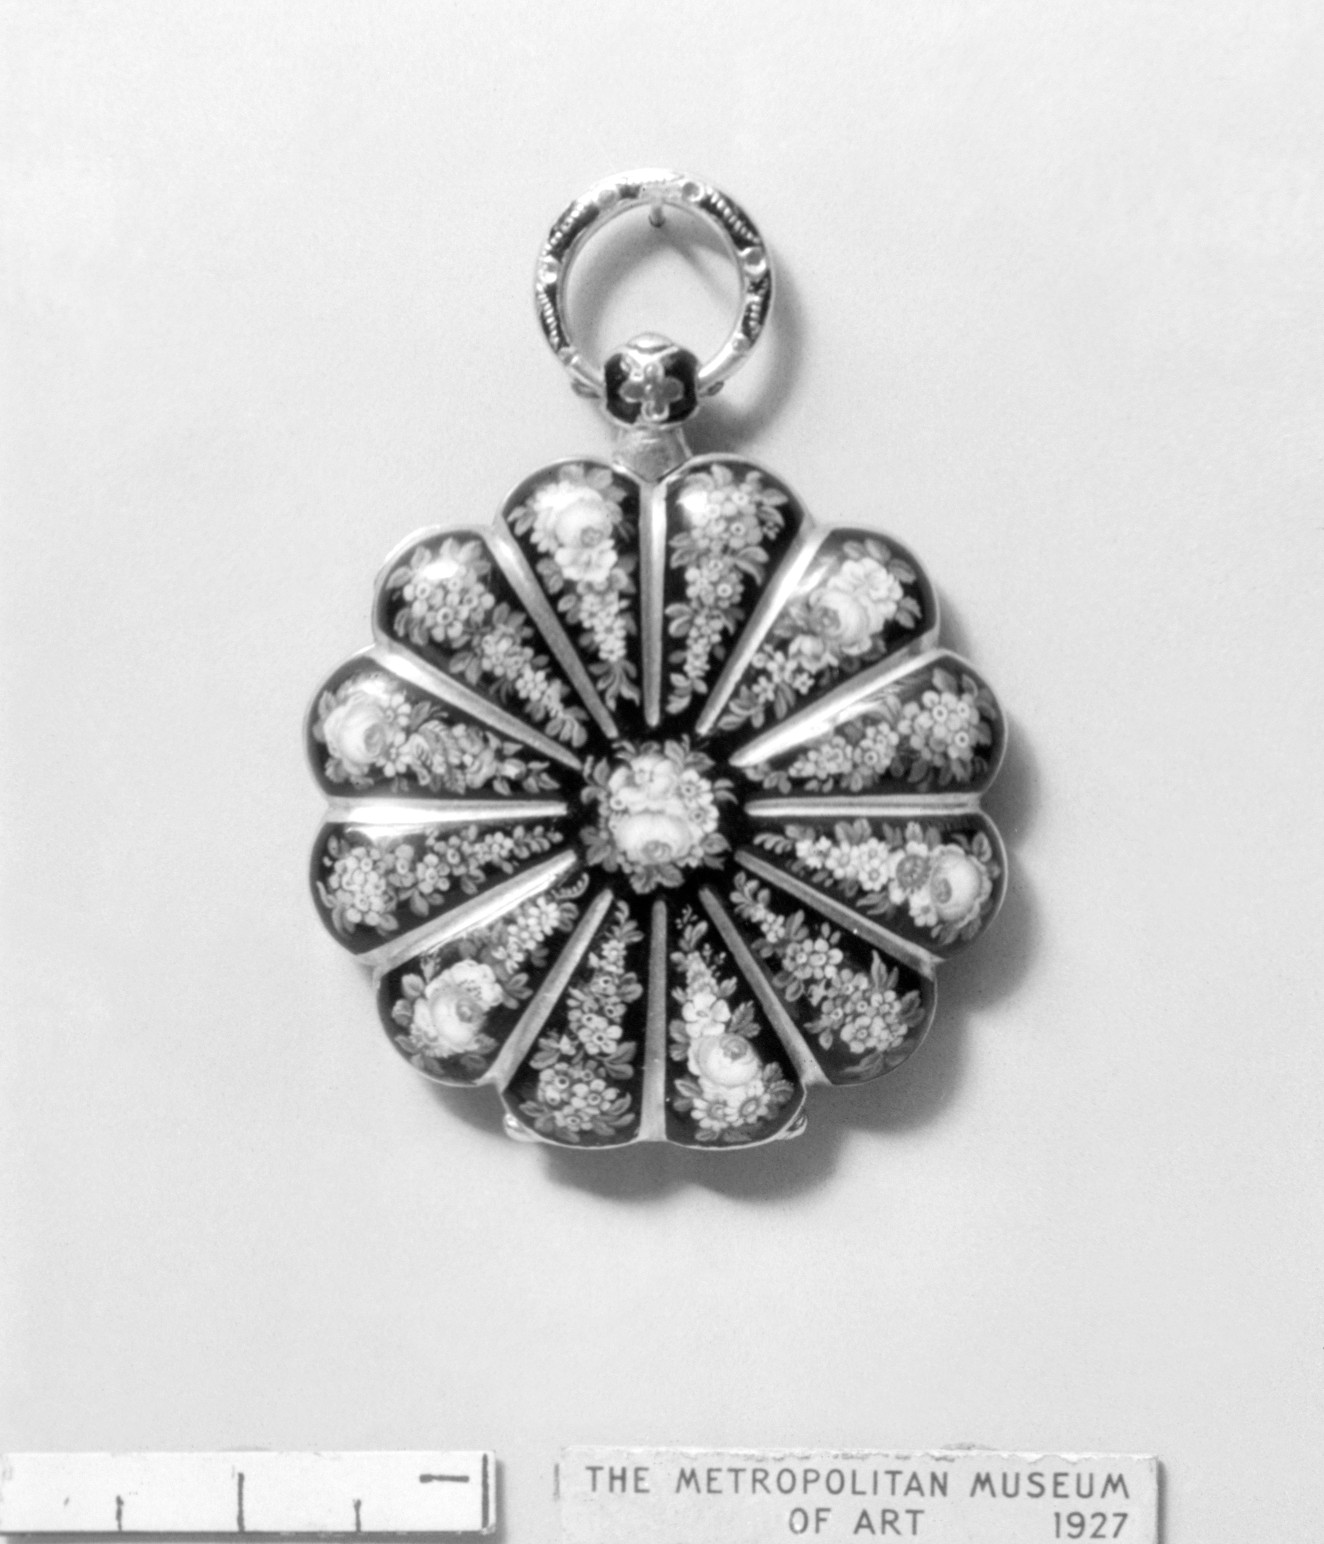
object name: watch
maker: george guignard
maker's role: maker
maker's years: 1775-1875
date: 1830-1840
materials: crystal, enamel, gold, silver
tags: flowers